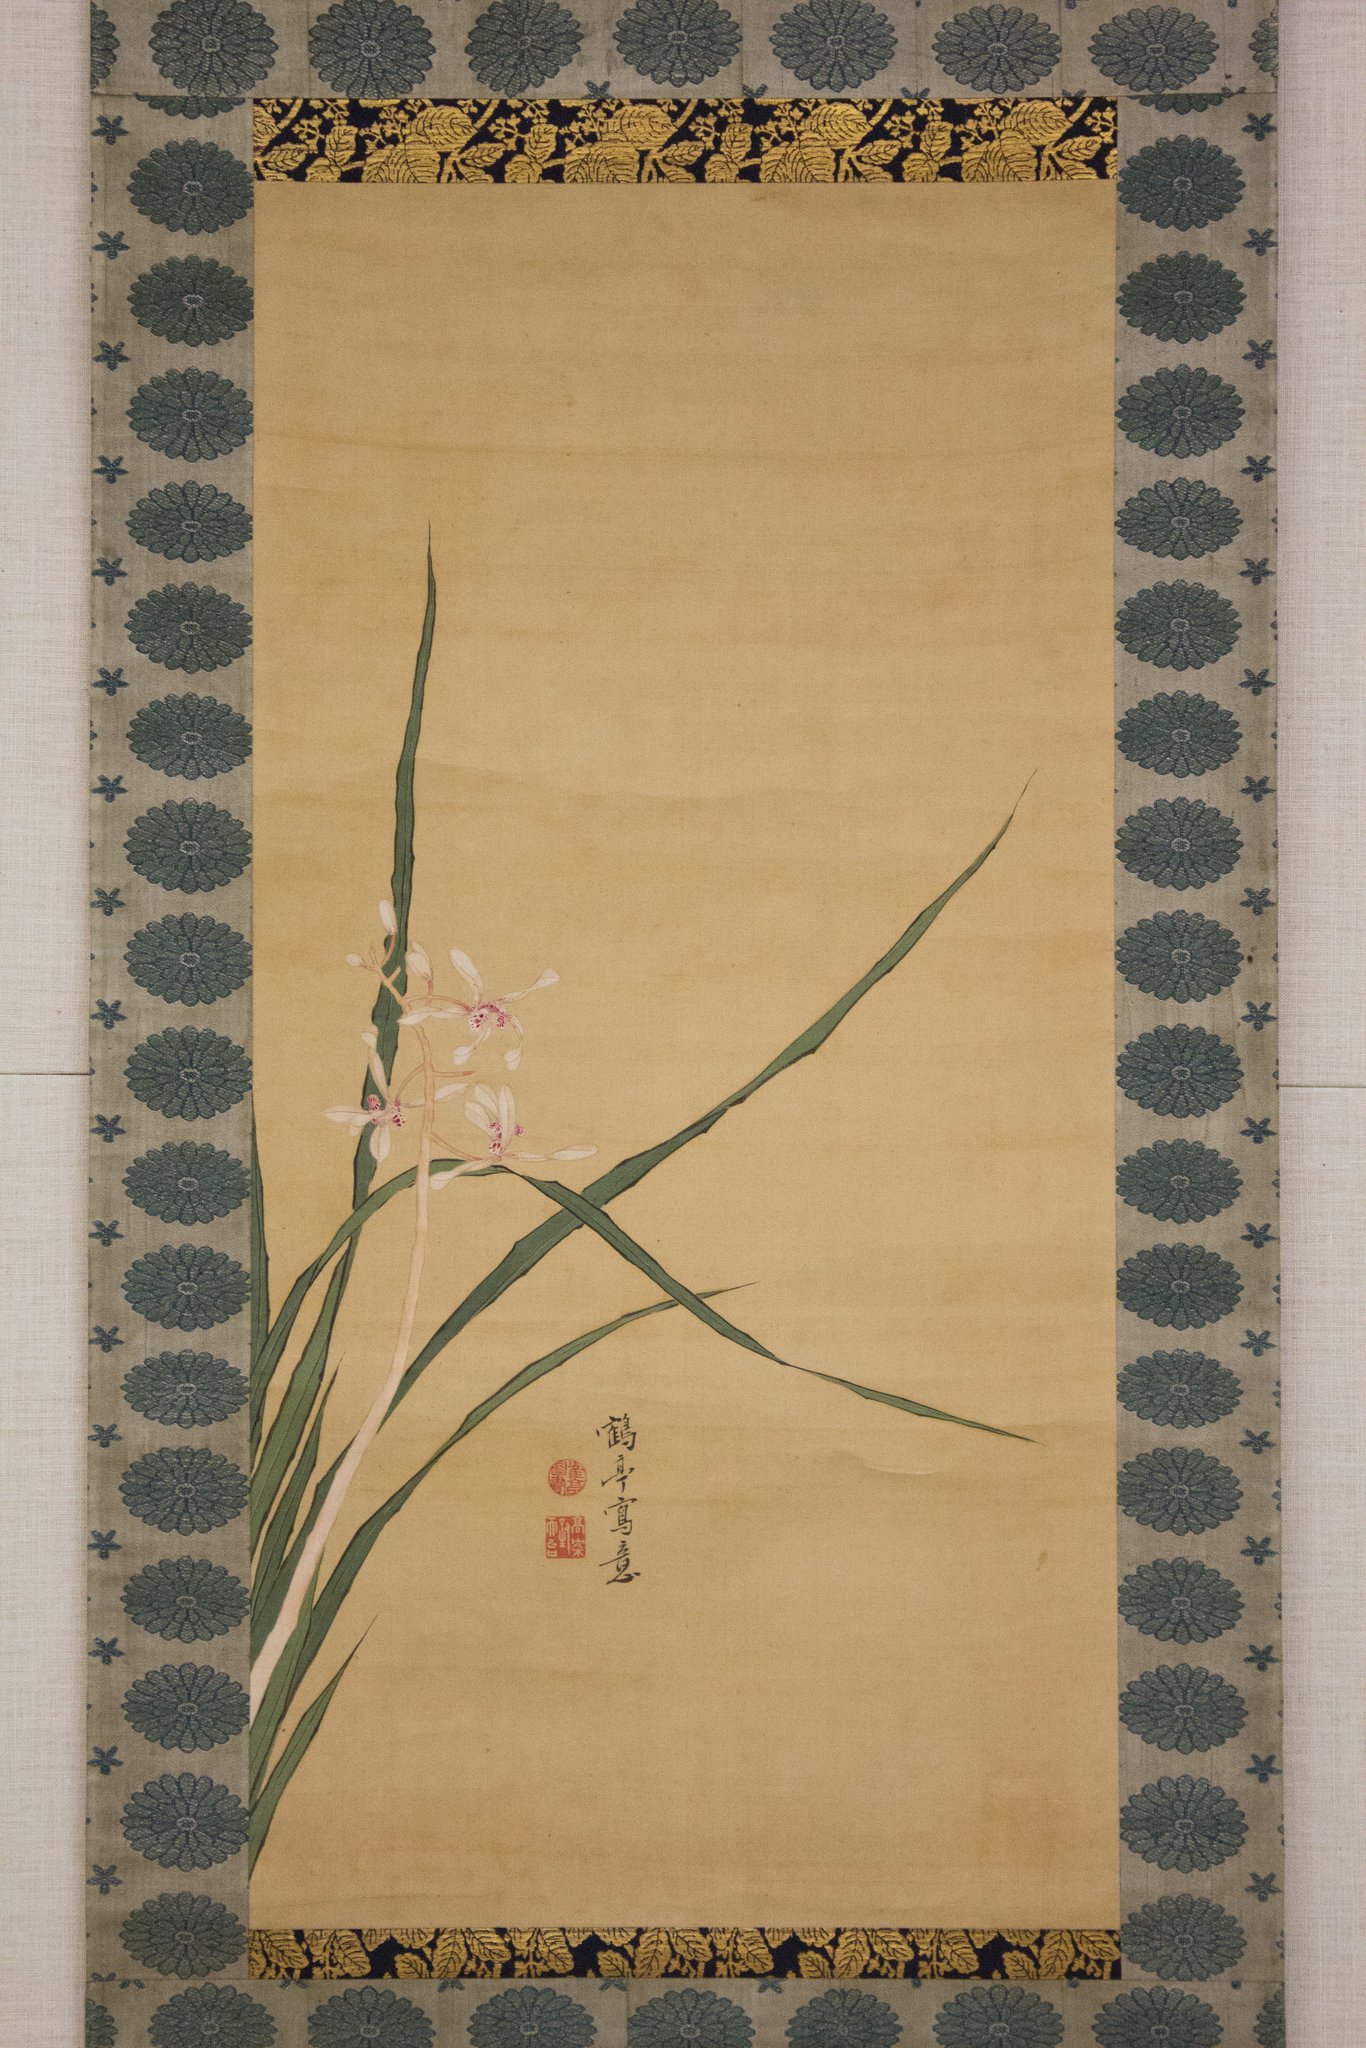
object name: hanging scroll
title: Orchid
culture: japanese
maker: kakutei (kaigan jōkō)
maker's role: artist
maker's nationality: japanese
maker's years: 1722-1785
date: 1734-1766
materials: ink, silk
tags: orchids